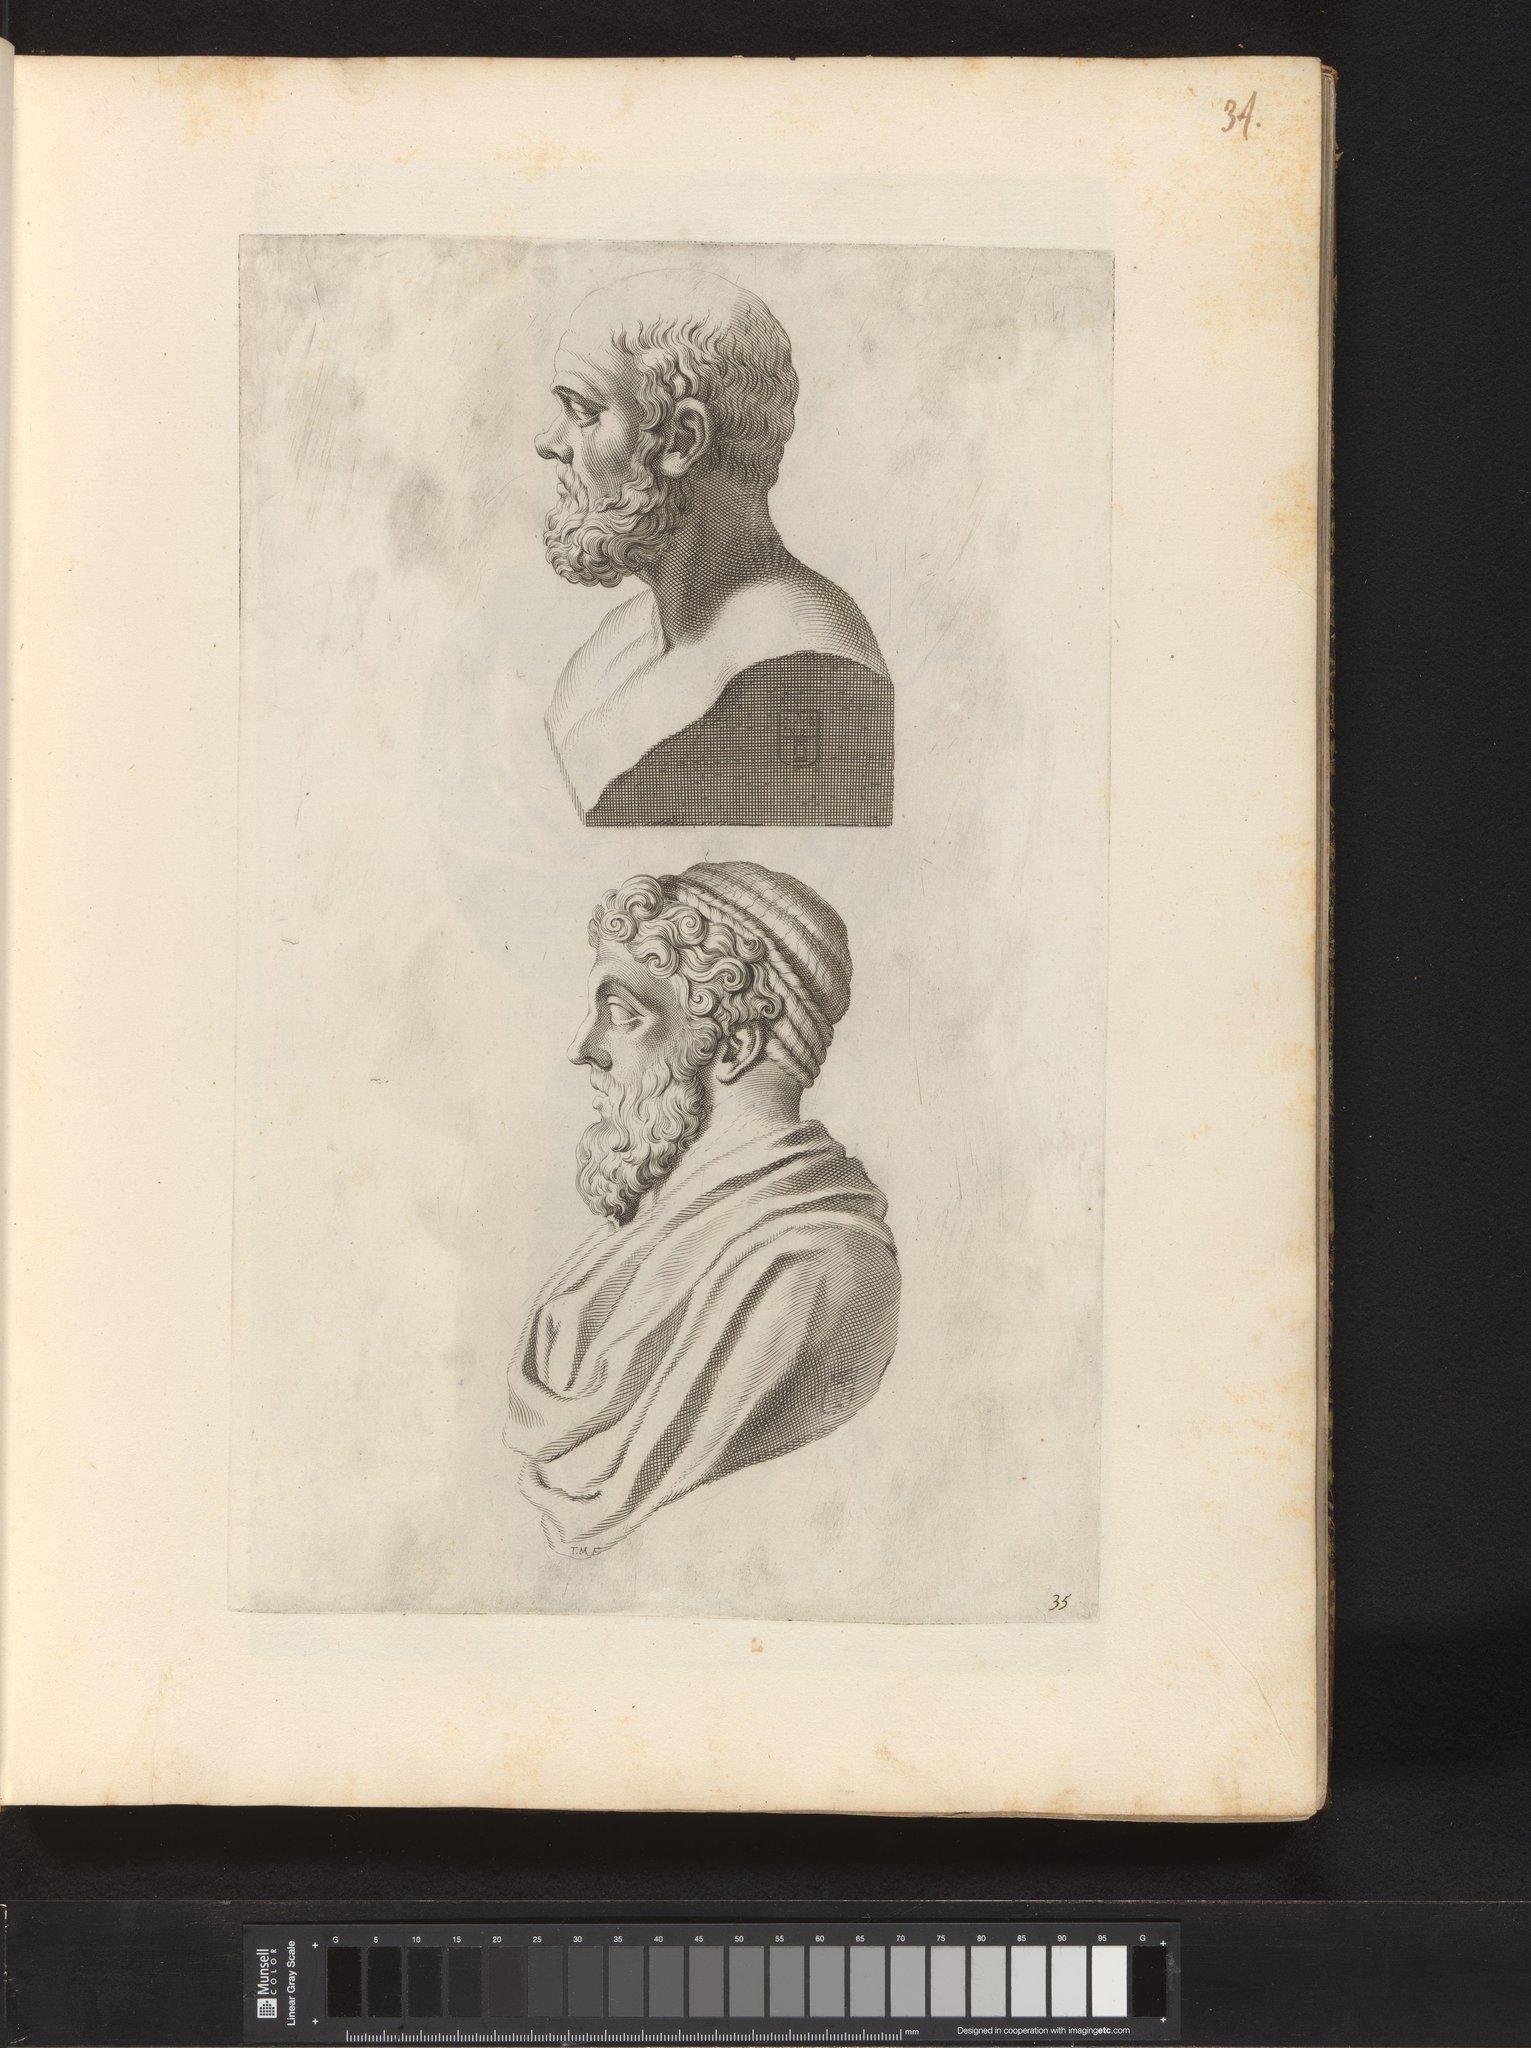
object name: print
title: Galleria Giustiniana del Marchese Vincenzo Giustiniani II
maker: theodor matham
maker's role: draughtsman, print maker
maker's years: 1605-1676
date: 1636-1647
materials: paper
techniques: engraving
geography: rome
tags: male persons from classical history (+ head, bust, etc.), piece of sculpture, reproduction of a piece of sculpture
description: Twee bustes van filosofen. Boven de buste van Antisthenes en onder van Cleisthenes. Op beide bustes het wapenschild van Vincenzo Giustiniani. Prent maakt deel uit van een album met een serie prenten naar de sculpturen in de verzameling in de Galleria Giustiniani te Rome.